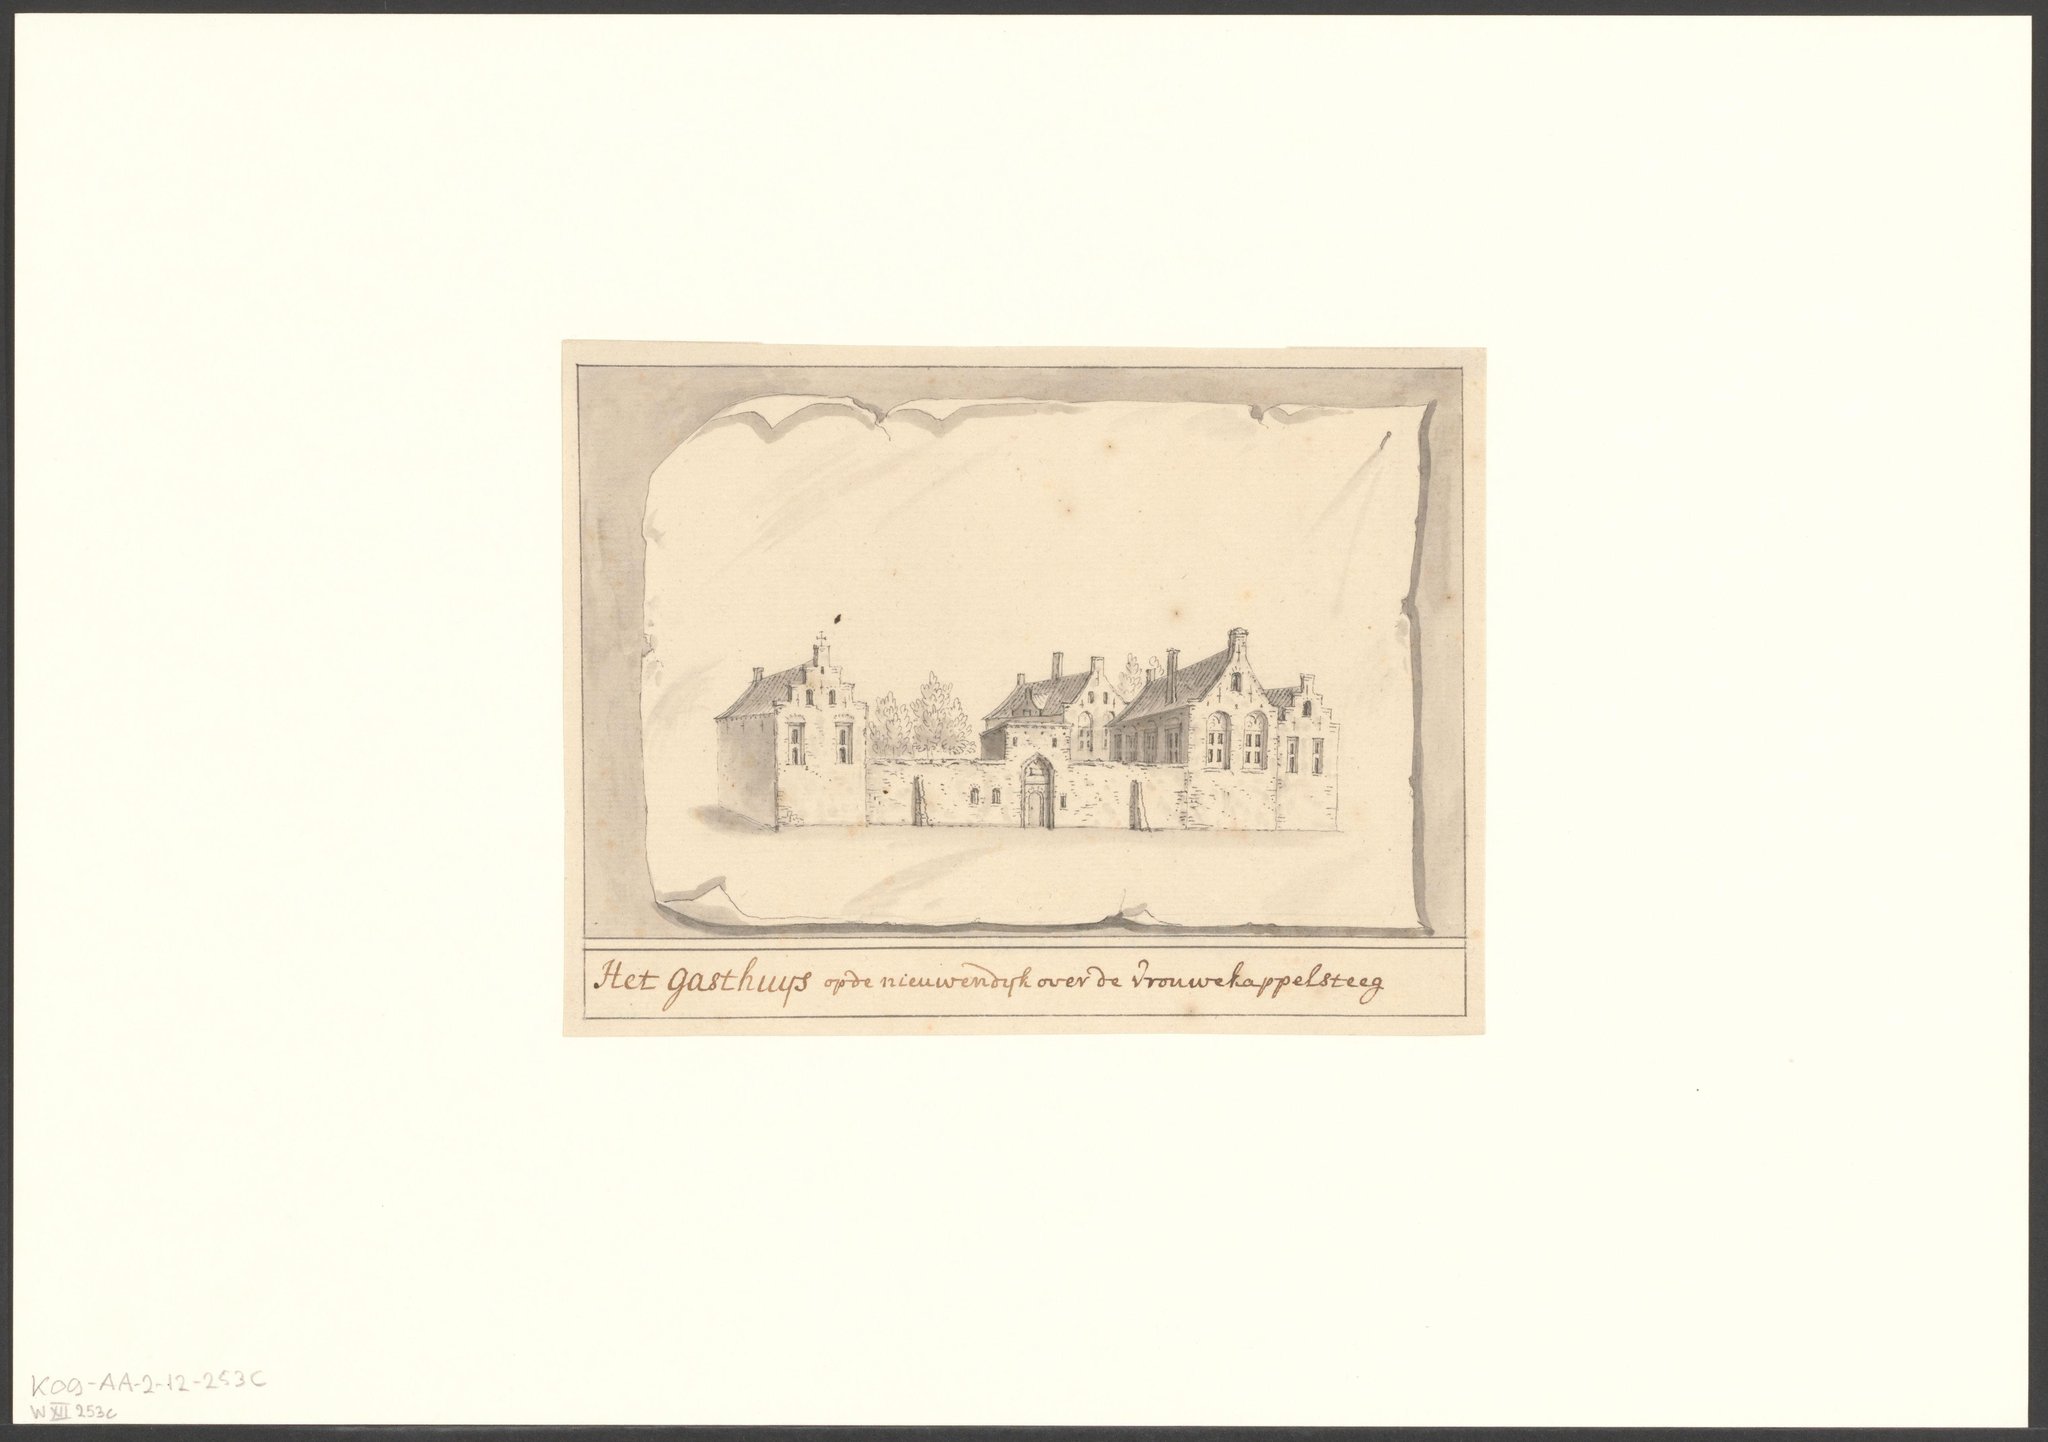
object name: drawing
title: Gezicht op het Onze Lieve Vrouwe Gasthuis aan de Nieuwendijk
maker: antonina houbraken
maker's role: draughtsman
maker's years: 1696-1736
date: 1706-1736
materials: ink, paper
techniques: brush, pen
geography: amsterdam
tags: city-view, and landscape with man-made constructions, hospital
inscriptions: inscription: ‘Het gasthuis opde nieuwendijk over de Vrouwekappelsteeg’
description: Tekening binnen de Atlas Van Eck ingedeeld op wijknummer 12.